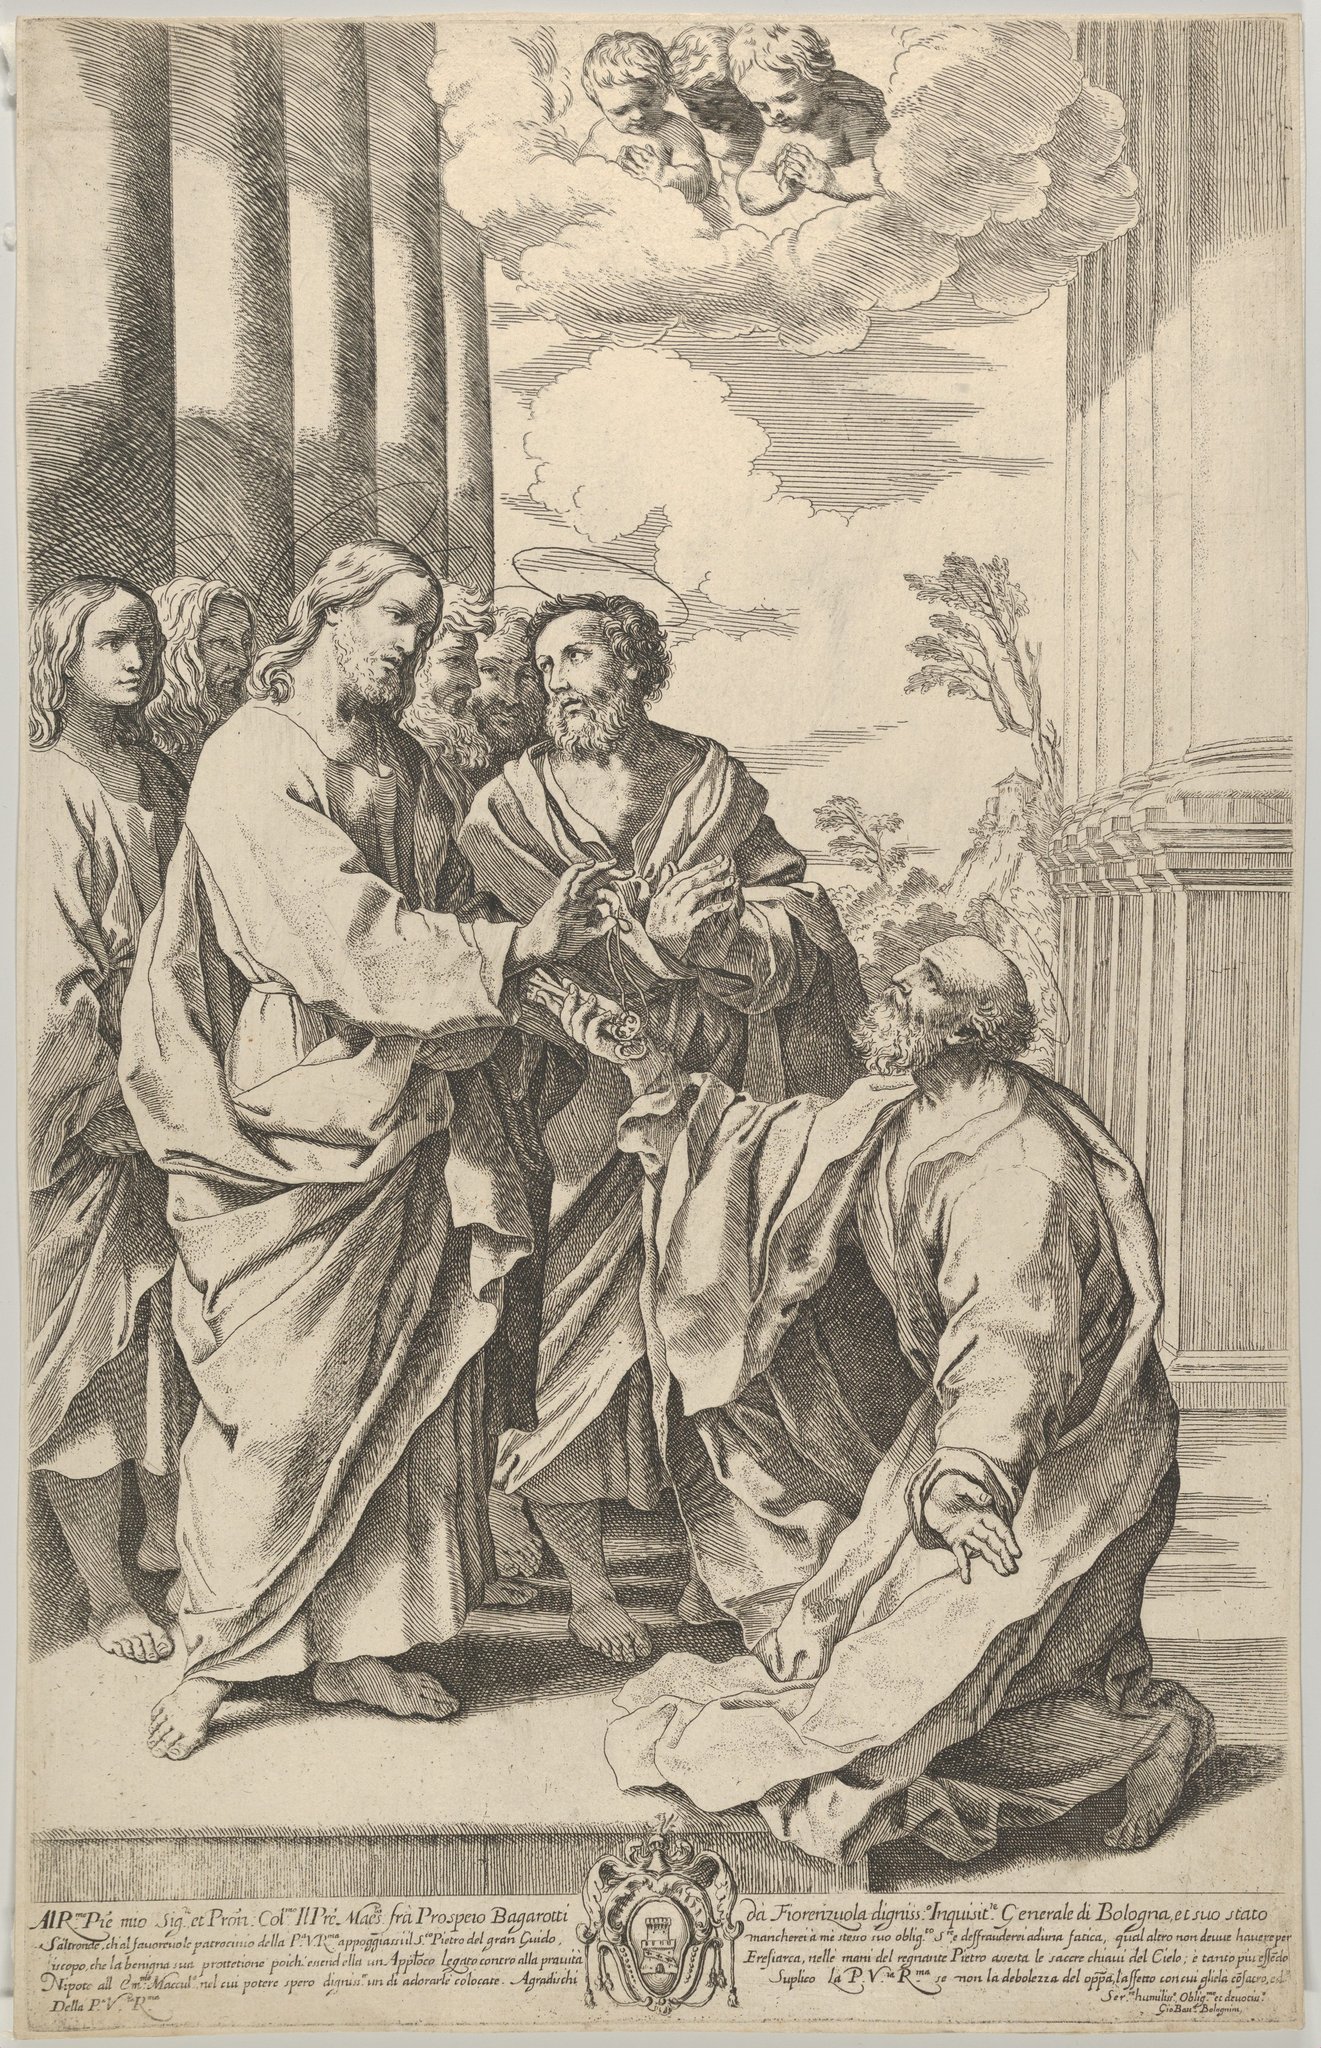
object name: print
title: Christ giving the keys of the church to Saint Peter who kneels before him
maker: gian battista bolognini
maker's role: artist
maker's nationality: italian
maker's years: 1611-1688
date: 1640-1670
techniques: etching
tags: men,christ,saint peter